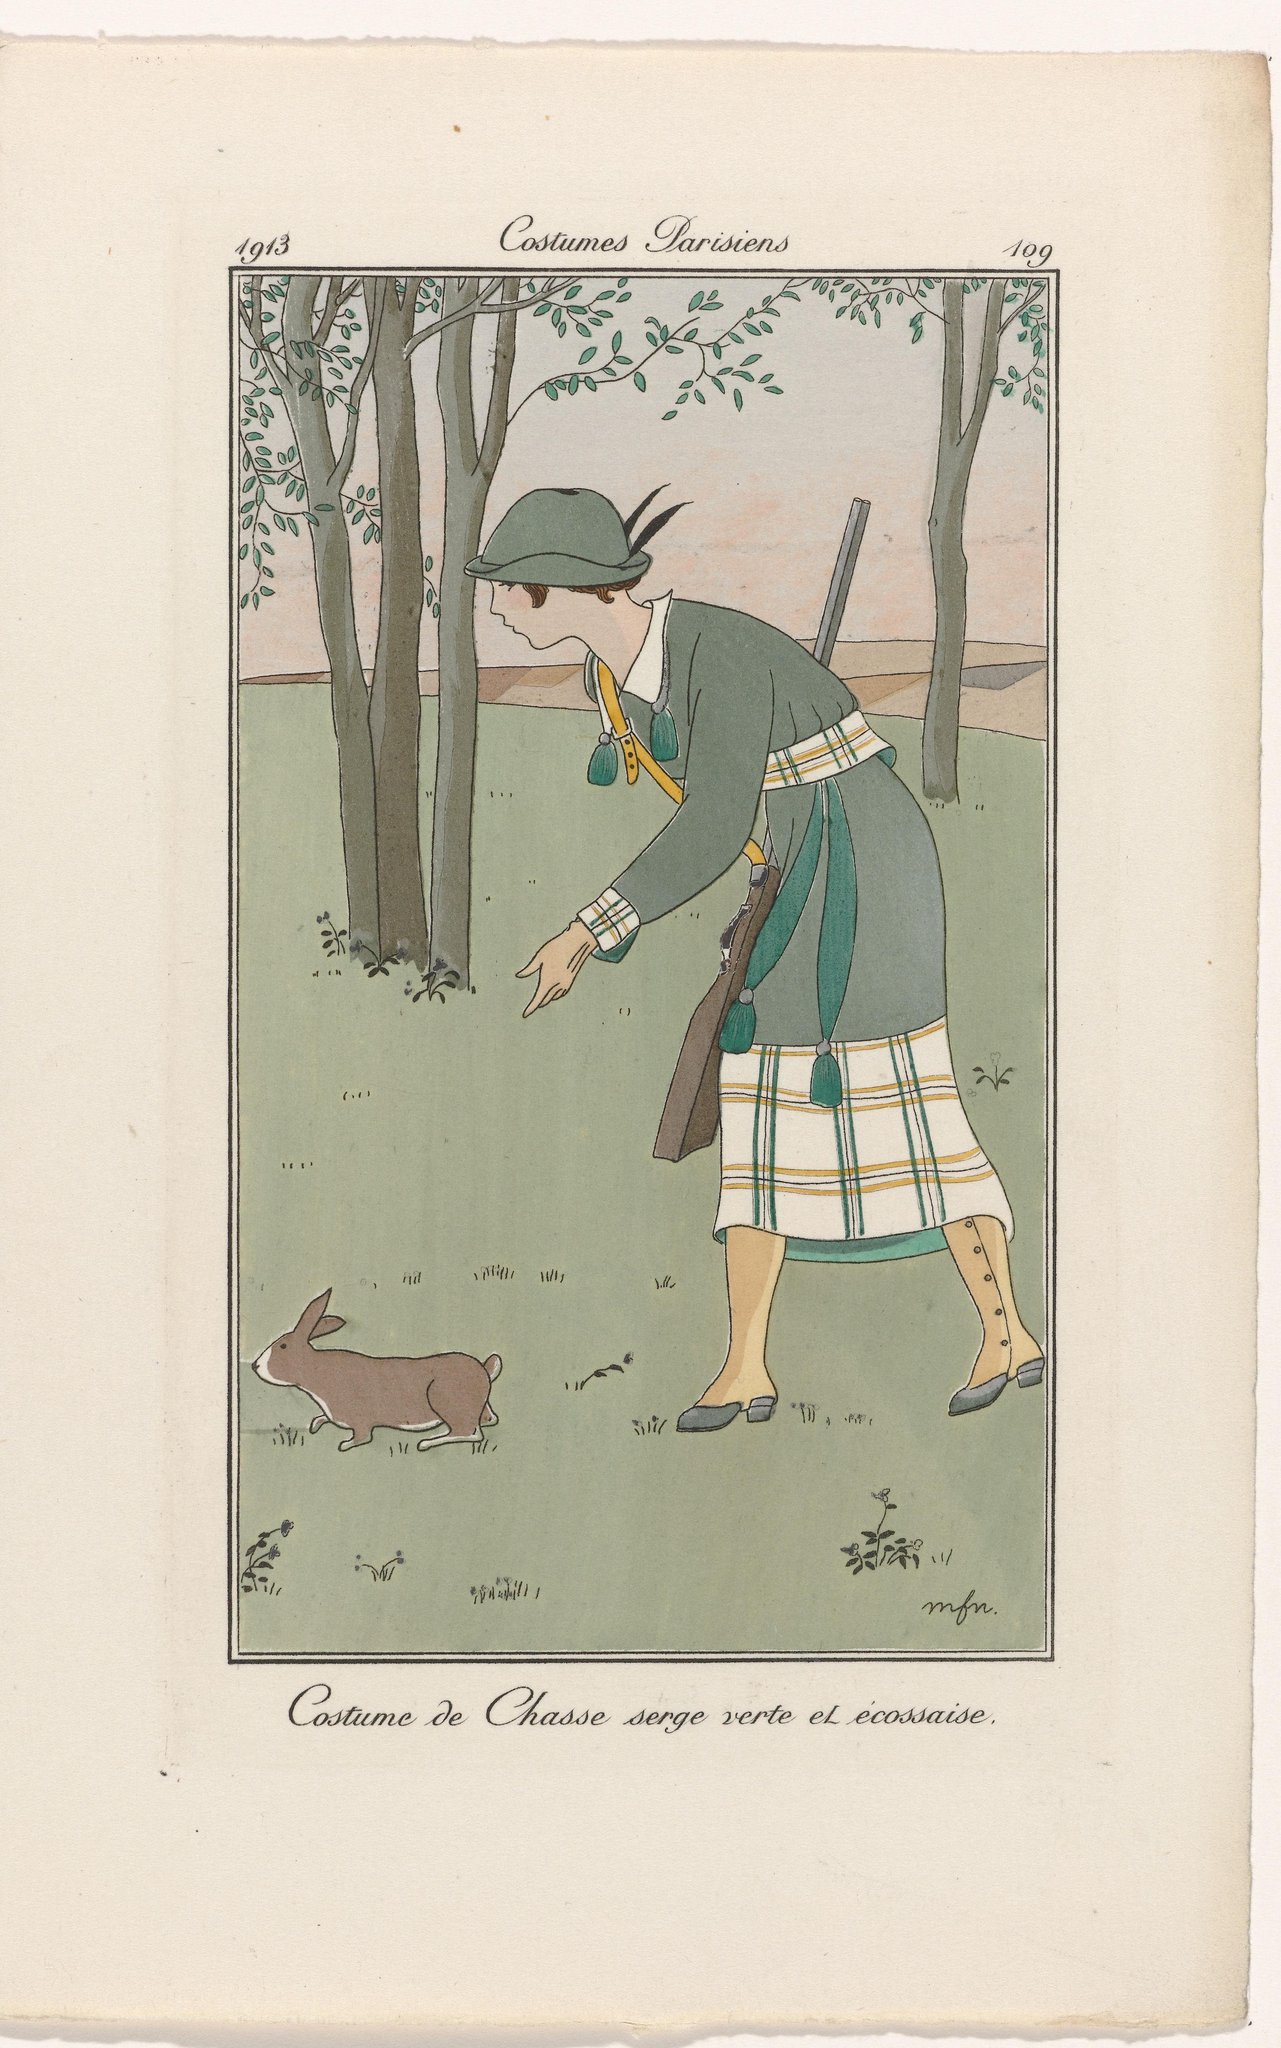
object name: fashion print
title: Journal des Dames et des Modes, Costumes Parisiens, 1913, No. 109 : Costume de Chass (...)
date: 1913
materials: paper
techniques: engraving, hand coloring, pochoir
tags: ensembles of pieces of clothing (hunting costume) (+ women's clothes), rodents: rabbit (+ man and animal), fashion plates, hunter - cc - female hunter, huntress, firearms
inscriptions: caption: ‘Costume de Chasse serge verte el écossaise.’, title: ‘Costumes Parisiens’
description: Vrouw in een jachtkostuum van groene en Schots geruite serge. Jachtgeweer om de schouder. Hoge slobkousen. Zij loopt achter een konijn aan.Prent uit het modetijdschrift Journal des Dames et des Modes (1912-1914).